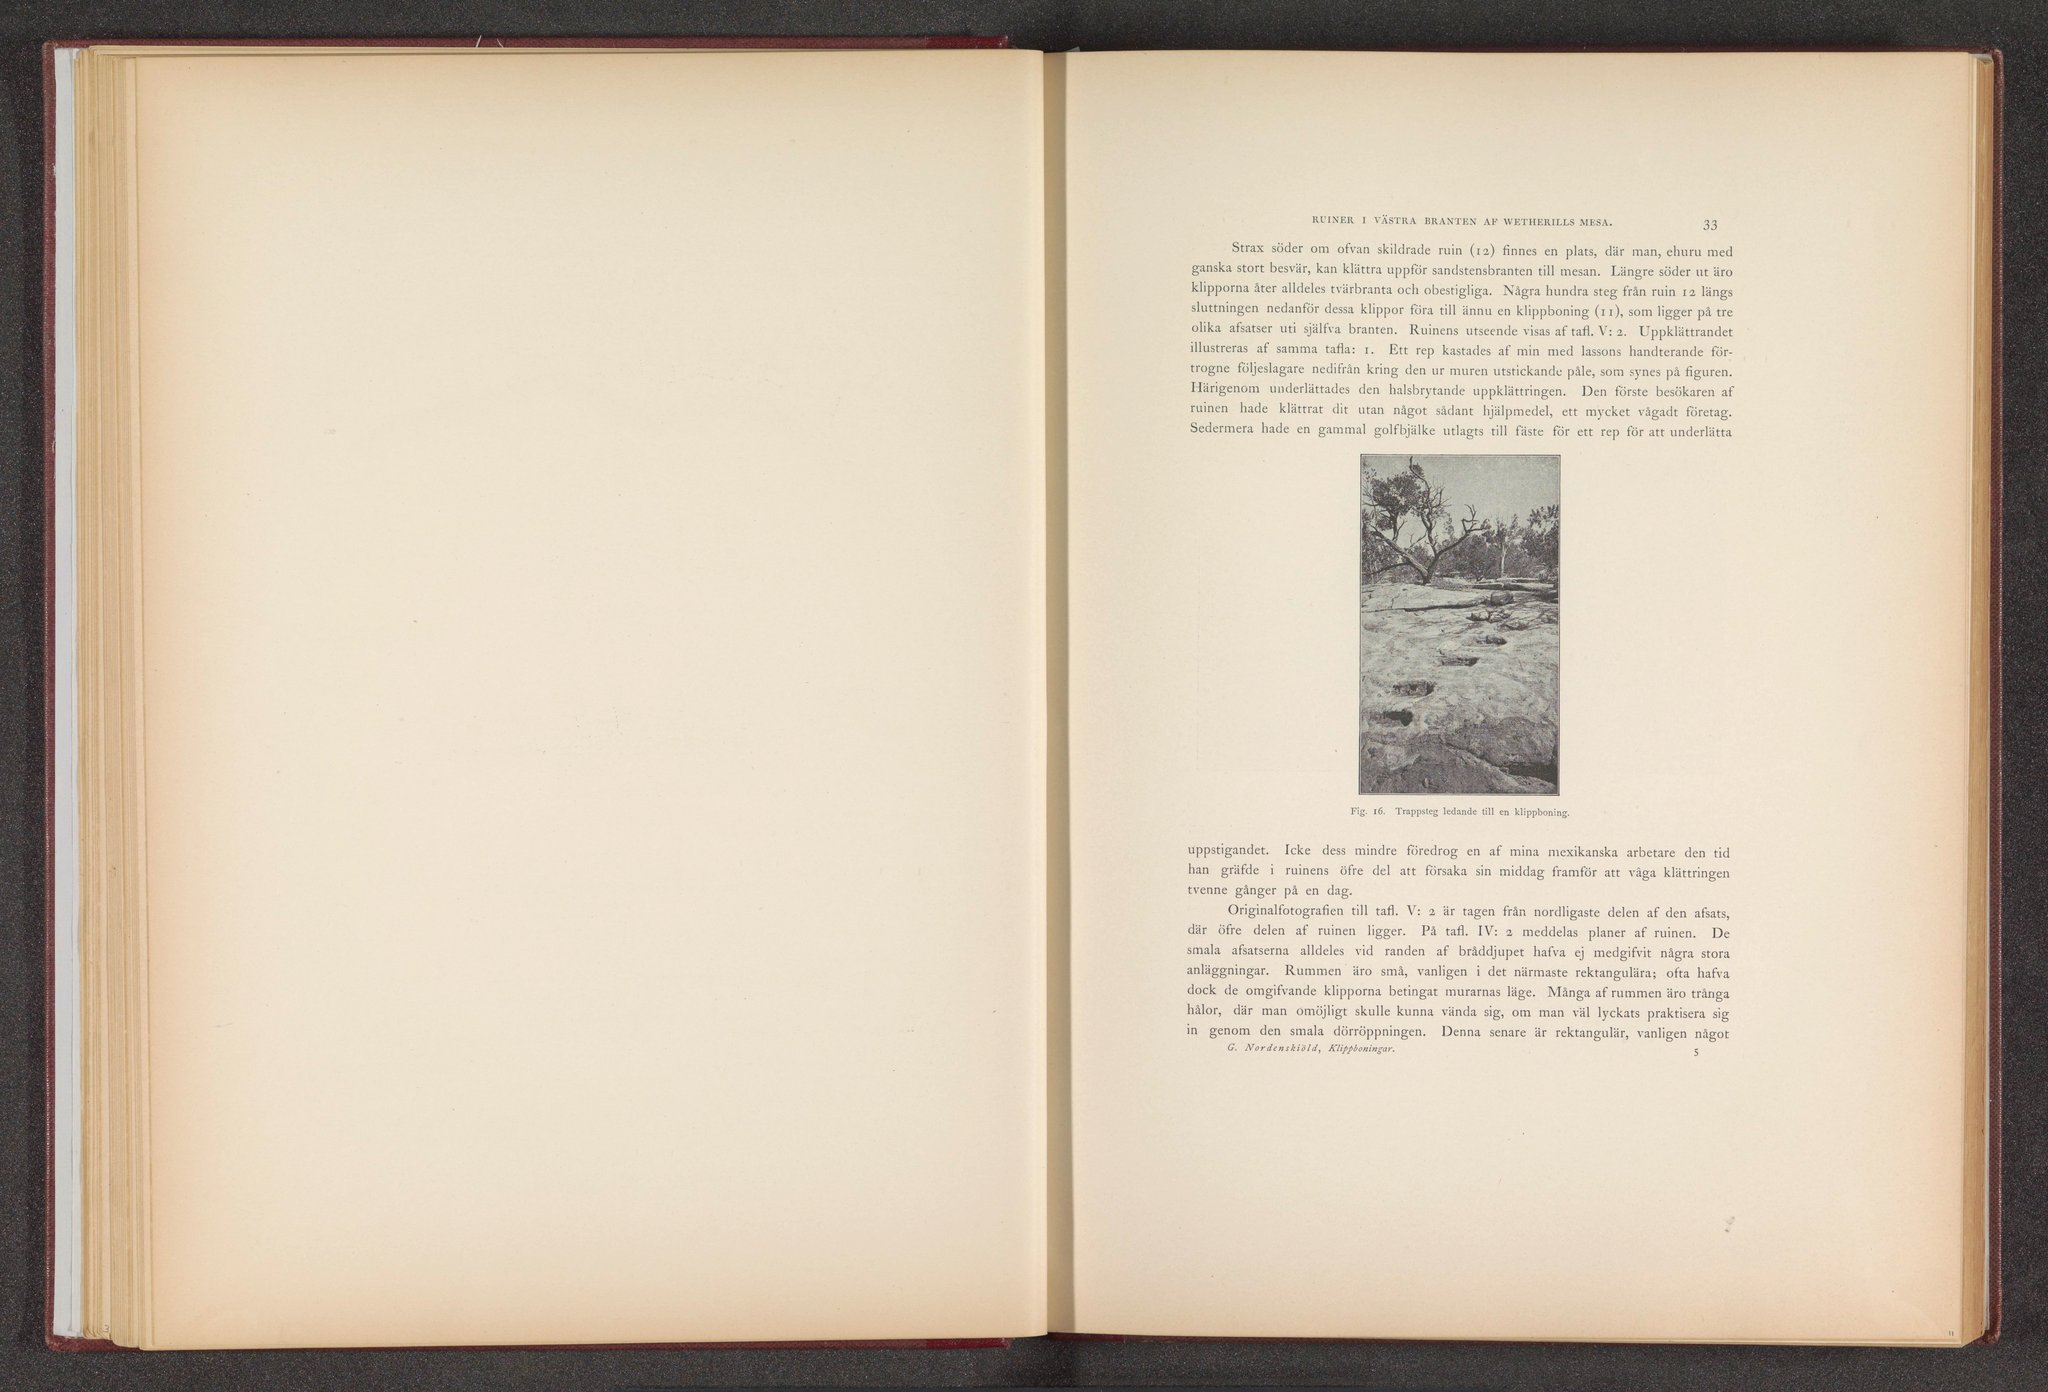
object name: page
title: Trappsteg ledande till en klippboning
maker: gustaf nordenskiöld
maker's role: fotograaf, schrijver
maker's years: 1868-1895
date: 1891-1893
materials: paper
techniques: autotype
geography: mesa verde national park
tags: cave-dwelling, staircase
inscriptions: number: ‘Fig. 16.’